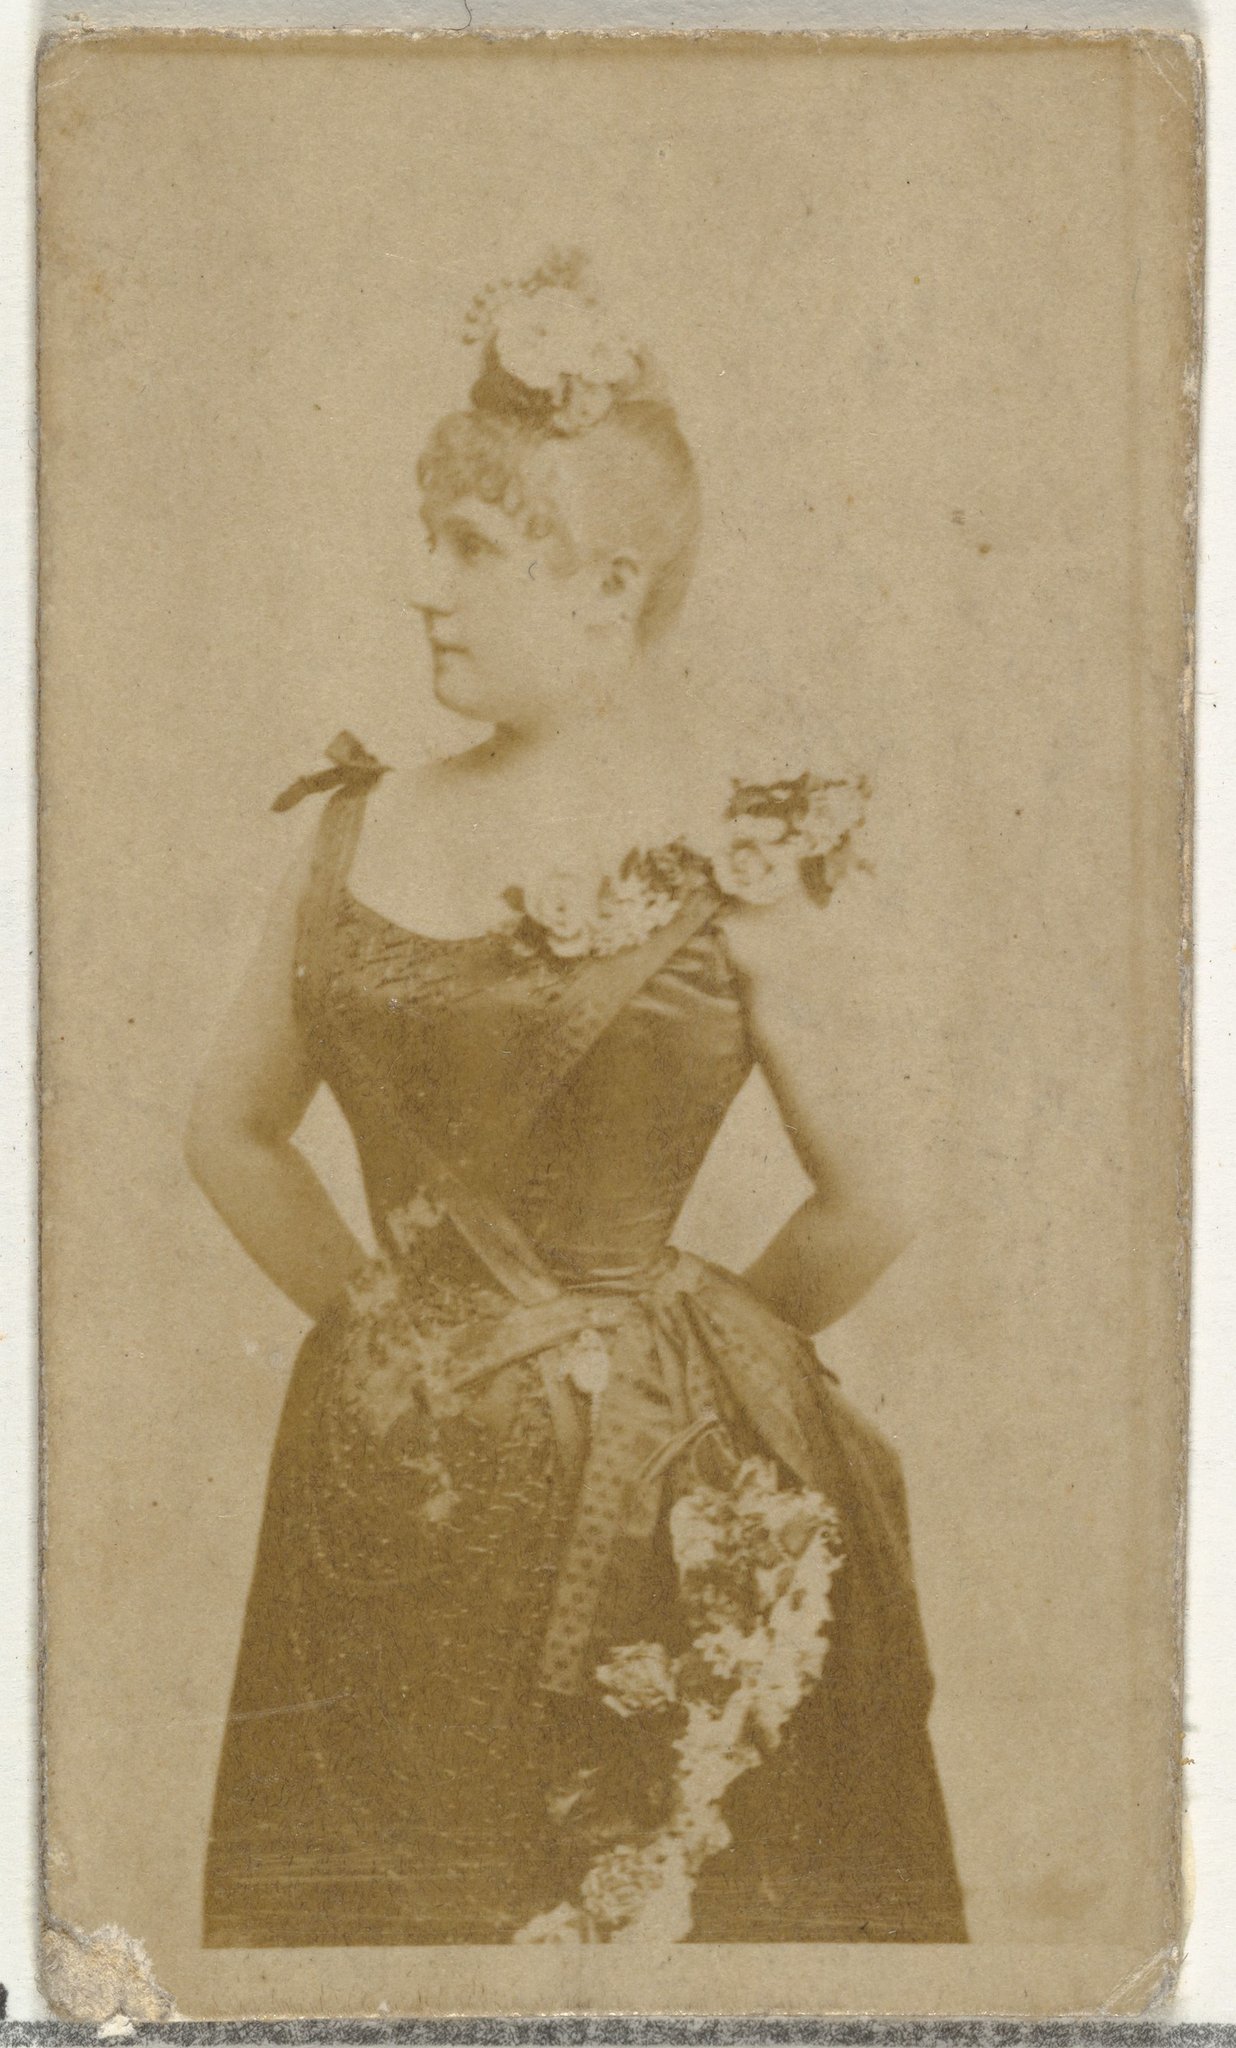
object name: photograph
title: [Actress wearing gown decorated with flowers], from the Actors and Actresses series (N145-8) issued by Duke Sons & Co. to promote Duke Cigarettes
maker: w. duke, sons & co.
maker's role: publisher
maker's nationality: american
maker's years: 1870-1920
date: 1891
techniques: albumen silver print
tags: women,actresses